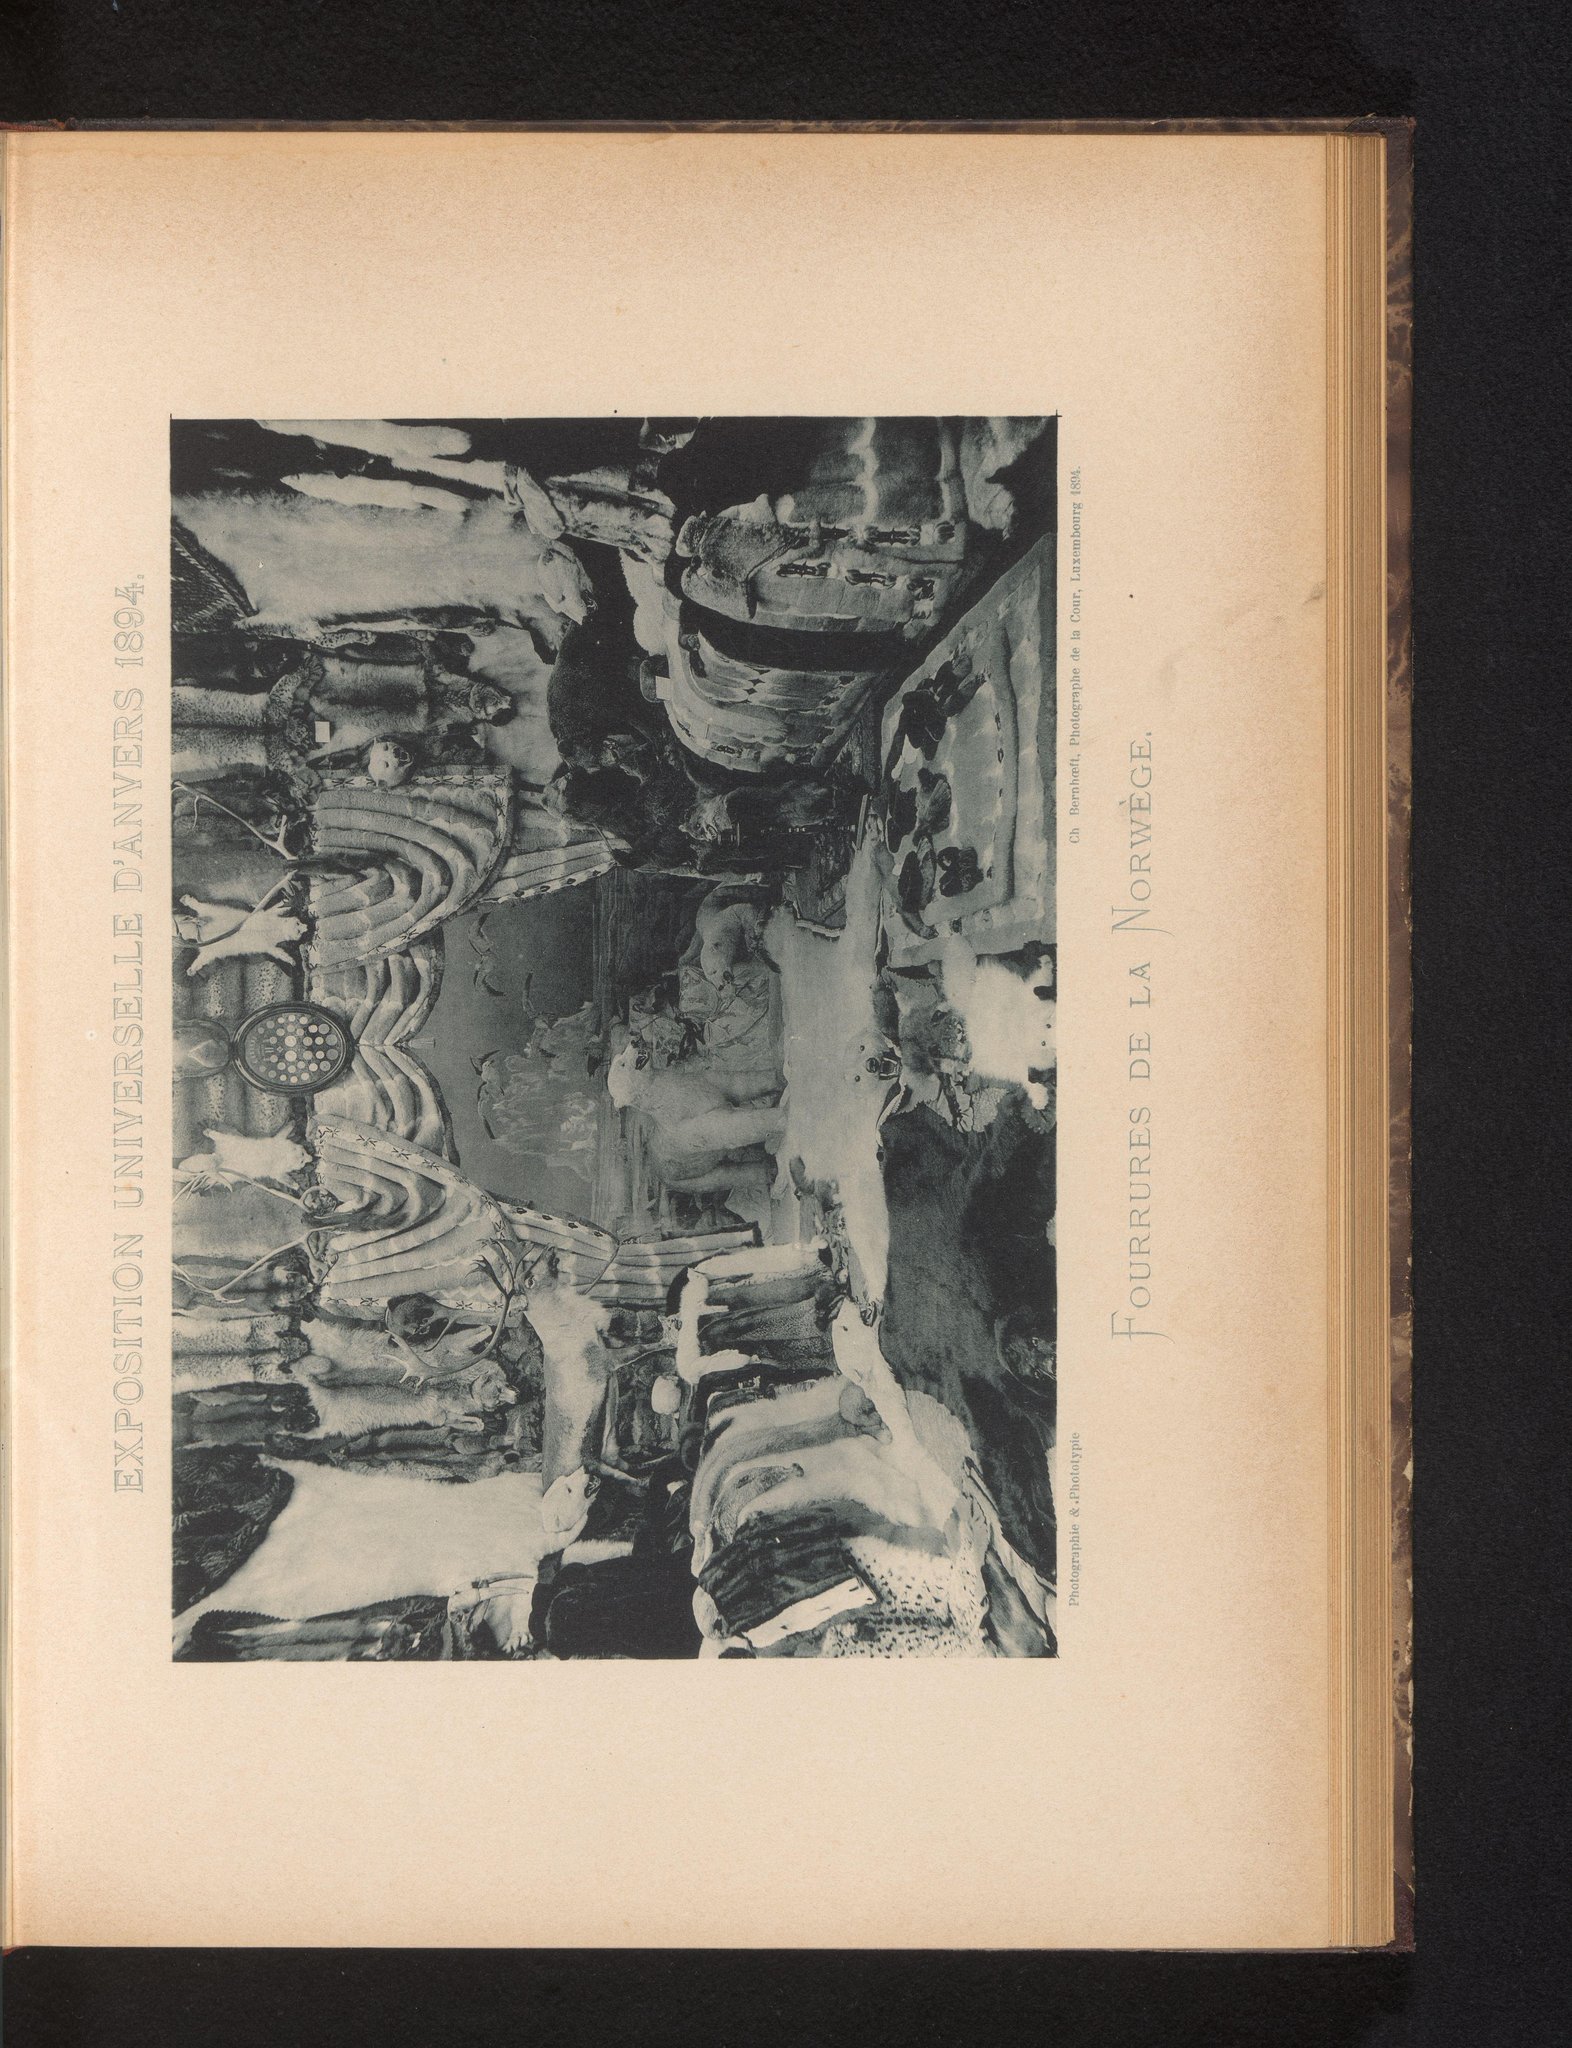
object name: page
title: Gezicht op bont uit Noorwegen op de Wereldtentoonstelling van Antwerpen in 1894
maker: charles bernhoeft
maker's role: publisher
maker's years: 1859-1933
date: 1894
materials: paper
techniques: photograph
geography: luxembourg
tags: world fair, world exhibition, handicrafts ~ animal material, skins, leather ~ building material, antwerp